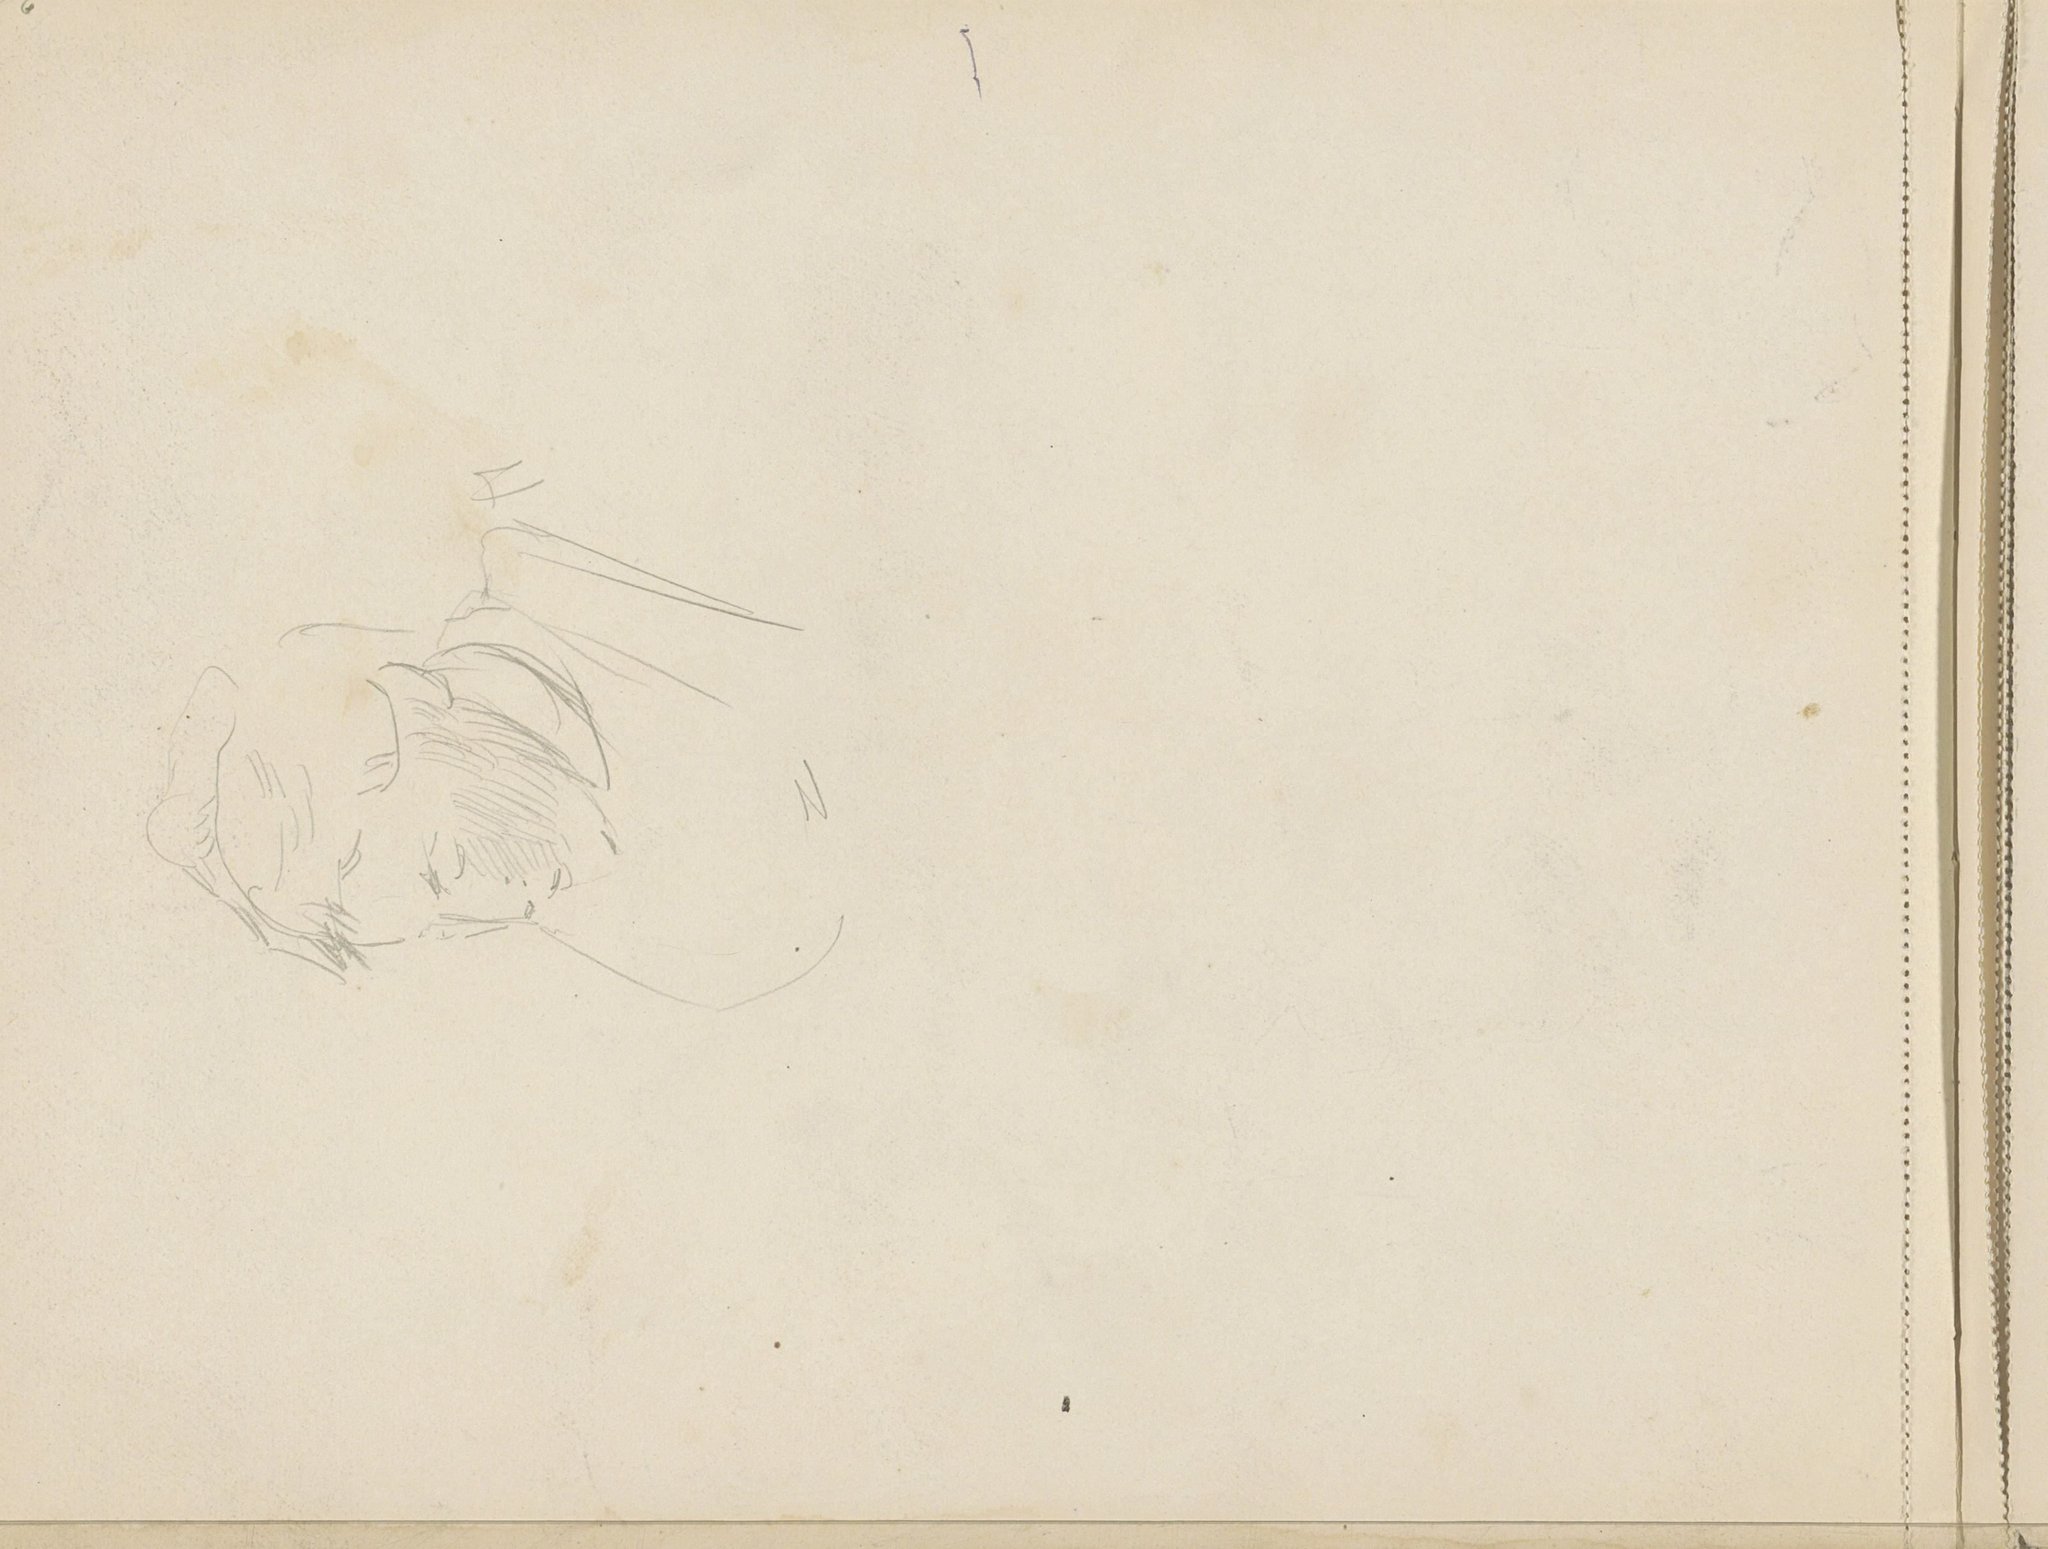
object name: sketchbook leaf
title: Vrouwenhoofd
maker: isaac israels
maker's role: draughtsman, painter, print maker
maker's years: 1865-1934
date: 1875-1934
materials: paper, pencil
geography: the hague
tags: head (human) - aa - female human figure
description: Blad 14 verso uit schetsboek XXIII met 20 bladen.